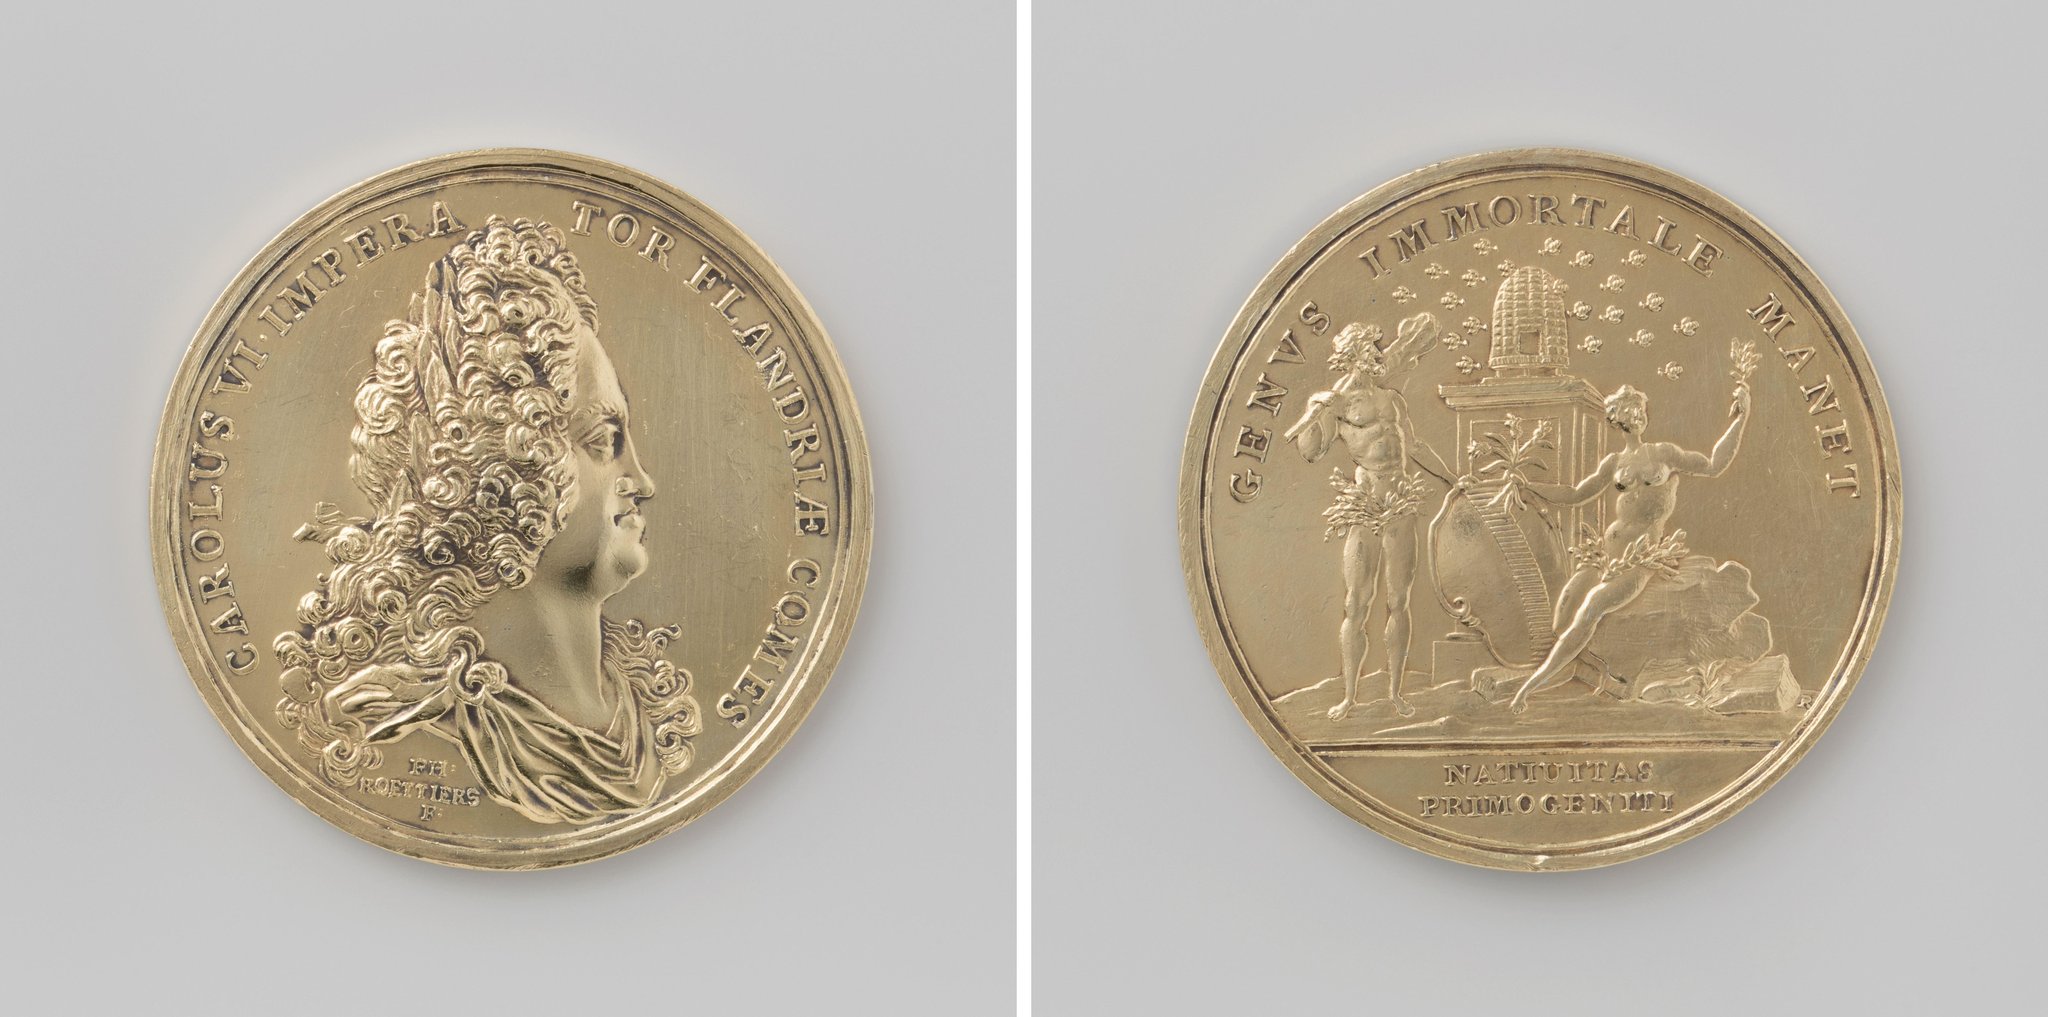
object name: history medal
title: Geboorte van prins Leopold van Oostenrijk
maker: philippe roëttiers (ii)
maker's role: medailleur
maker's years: 1640-1718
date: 1716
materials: silver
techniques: gilding, striking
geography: antwerp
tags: vienna, charles vi (holy roman emperor)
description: Zilveren penning. Voorzijde: borststuk man met lauwerkrans binnen omschrift. Keerzijde: Herkules met knots op zijn schouder en nimf met in ene hand tak en in andere bloemen, houden samen wapenschild vast, op achtergrond bijenkorf op een voetstuk binnen omschrift; afsnede: opschrift.